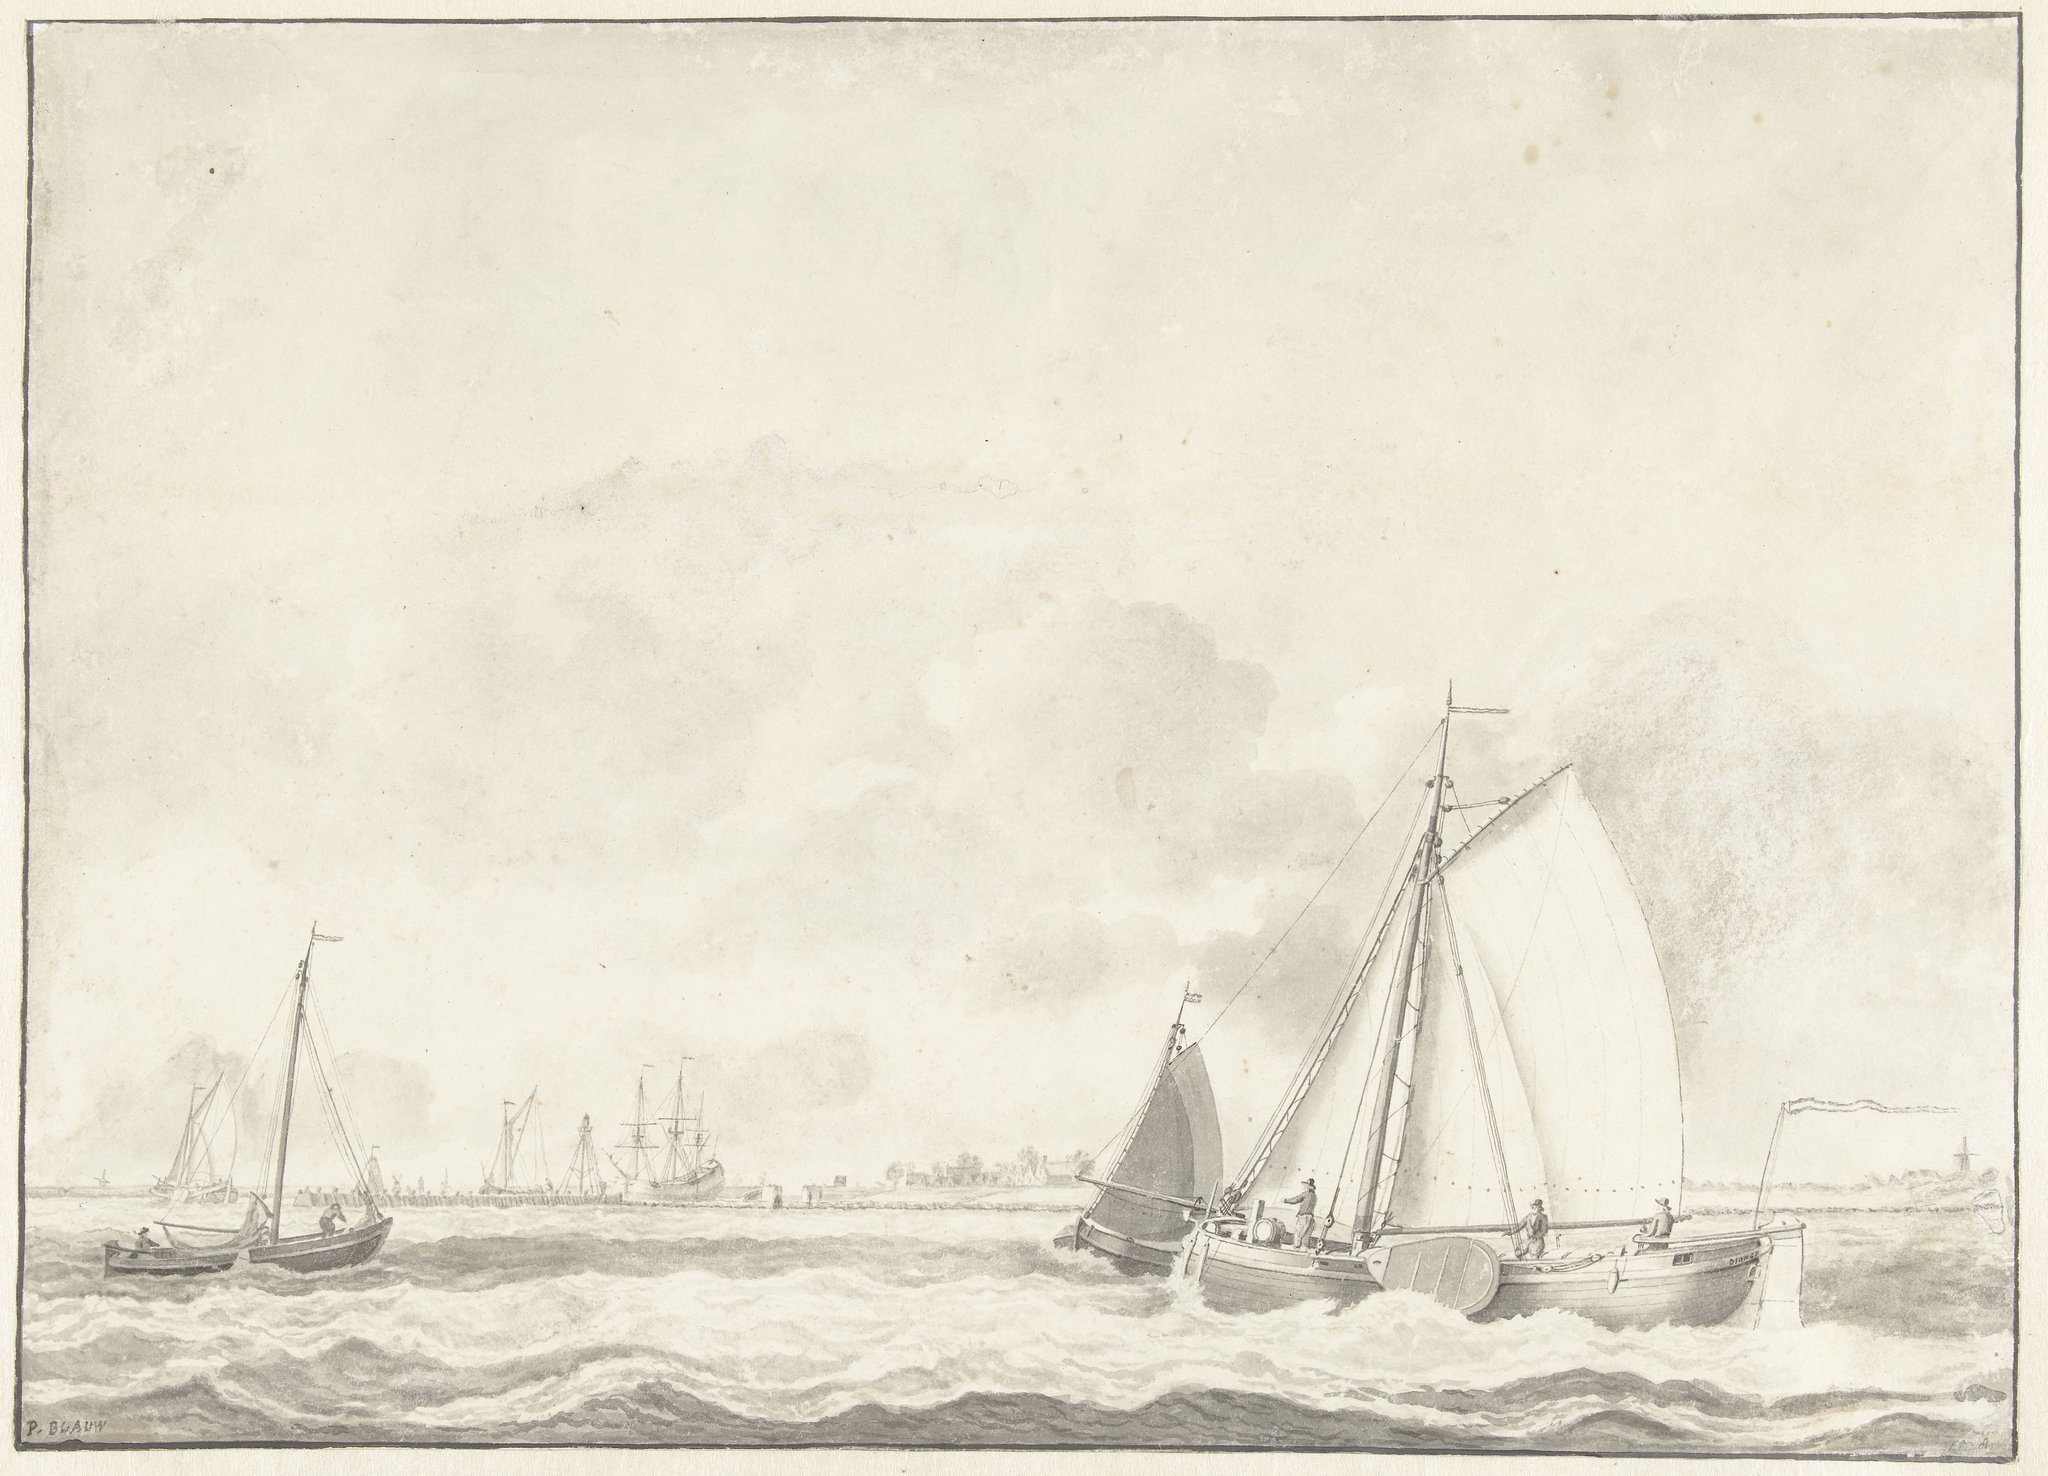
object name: drawing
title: Zeegezicht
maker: pieter blaauw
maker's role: draughtsman, painter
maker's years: 1744-1808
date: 1754-1808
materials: ink, paper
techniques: brush, pen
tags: sea (seascape)